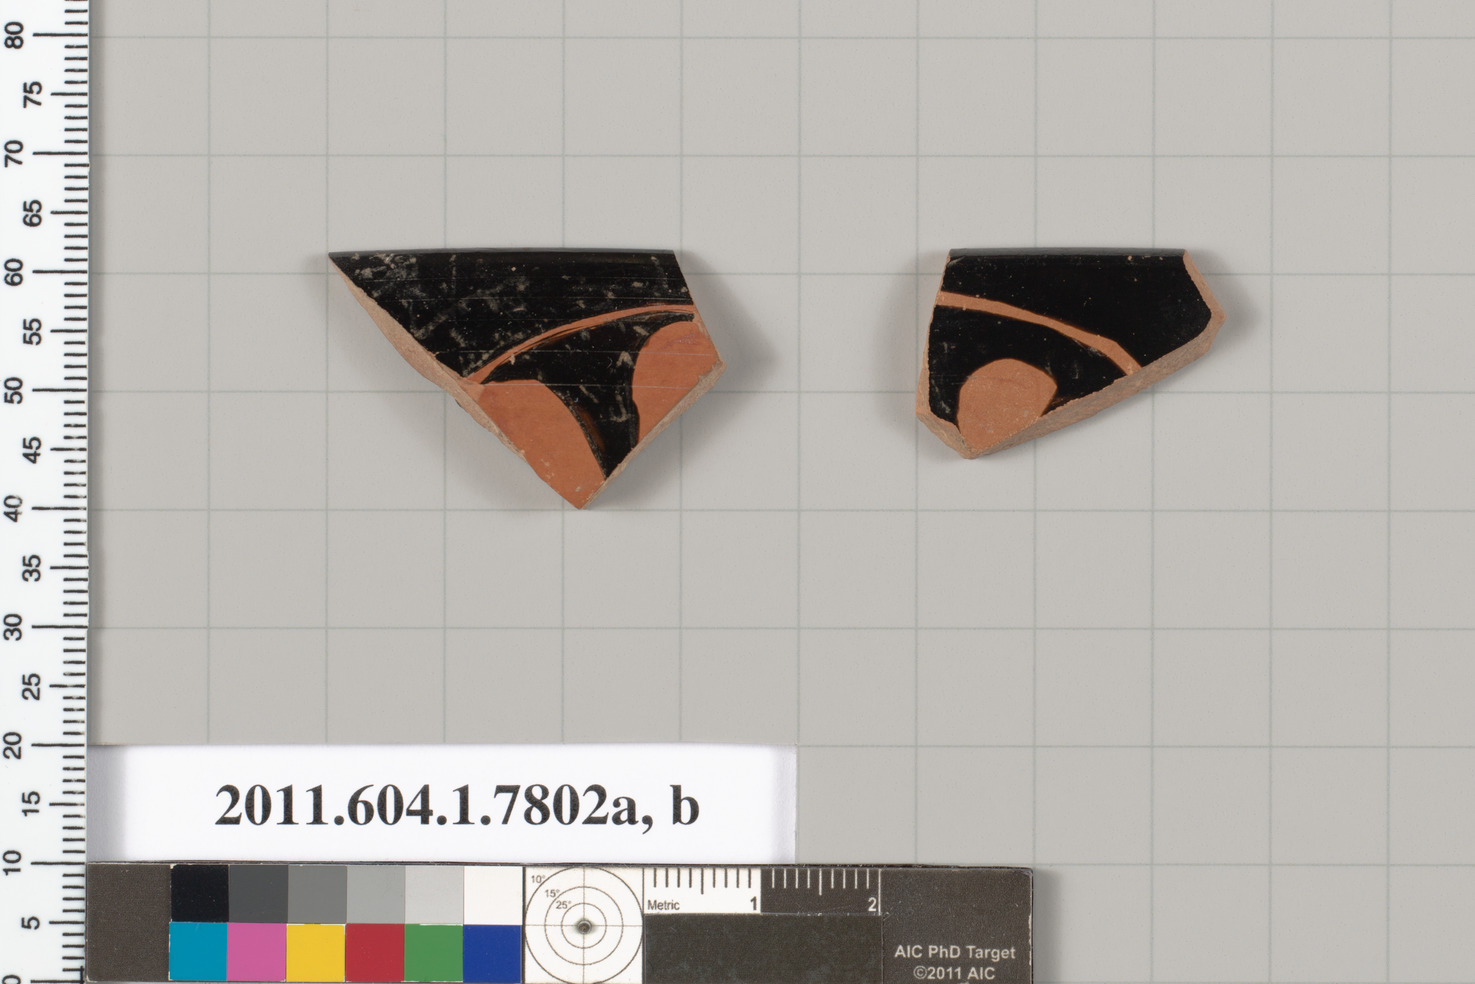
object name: kylix fragment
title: Terracotta rim fragments of kylikes (drinking cups)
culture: greek, attic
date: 480-460 BCE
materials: terracotta